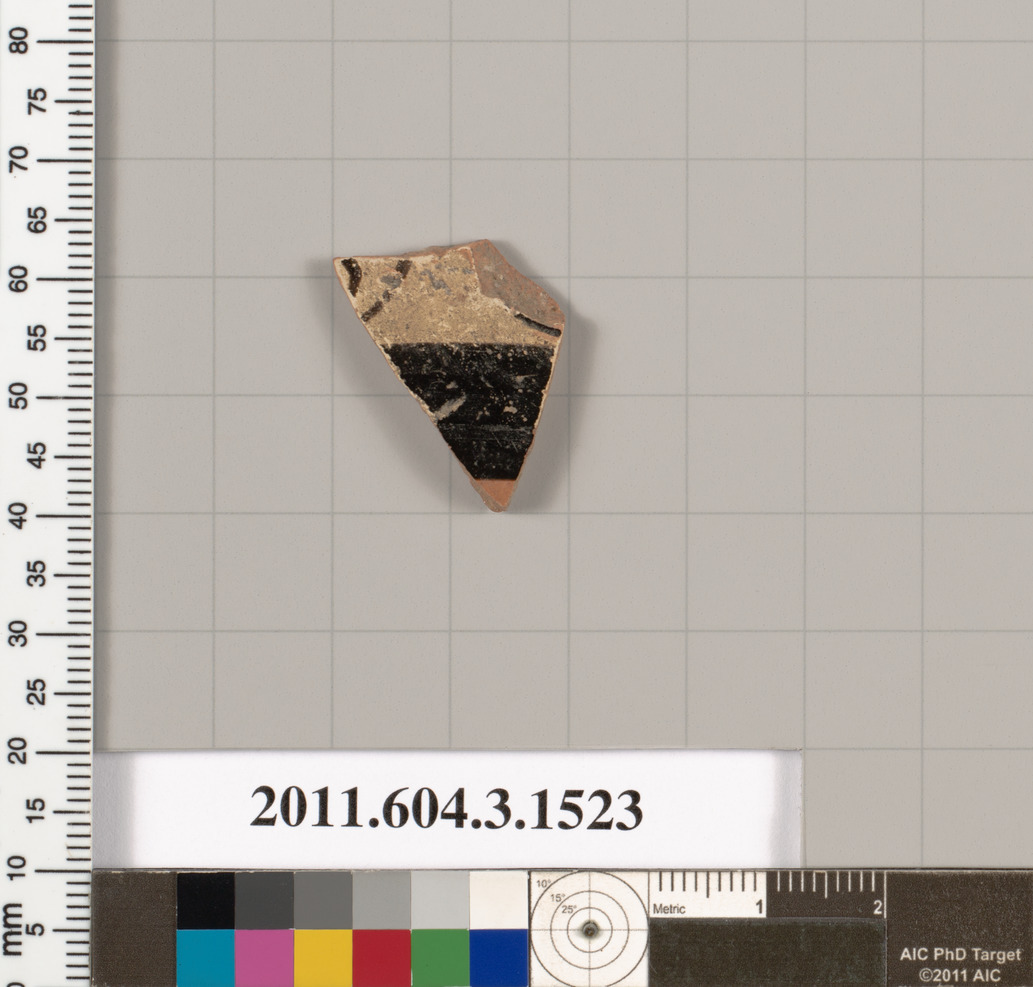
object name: skyphos fragment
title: Terracotta fragment of a skyphos (deep drinking cup)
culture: greek, attic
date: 534-468 BCE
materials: terracotta